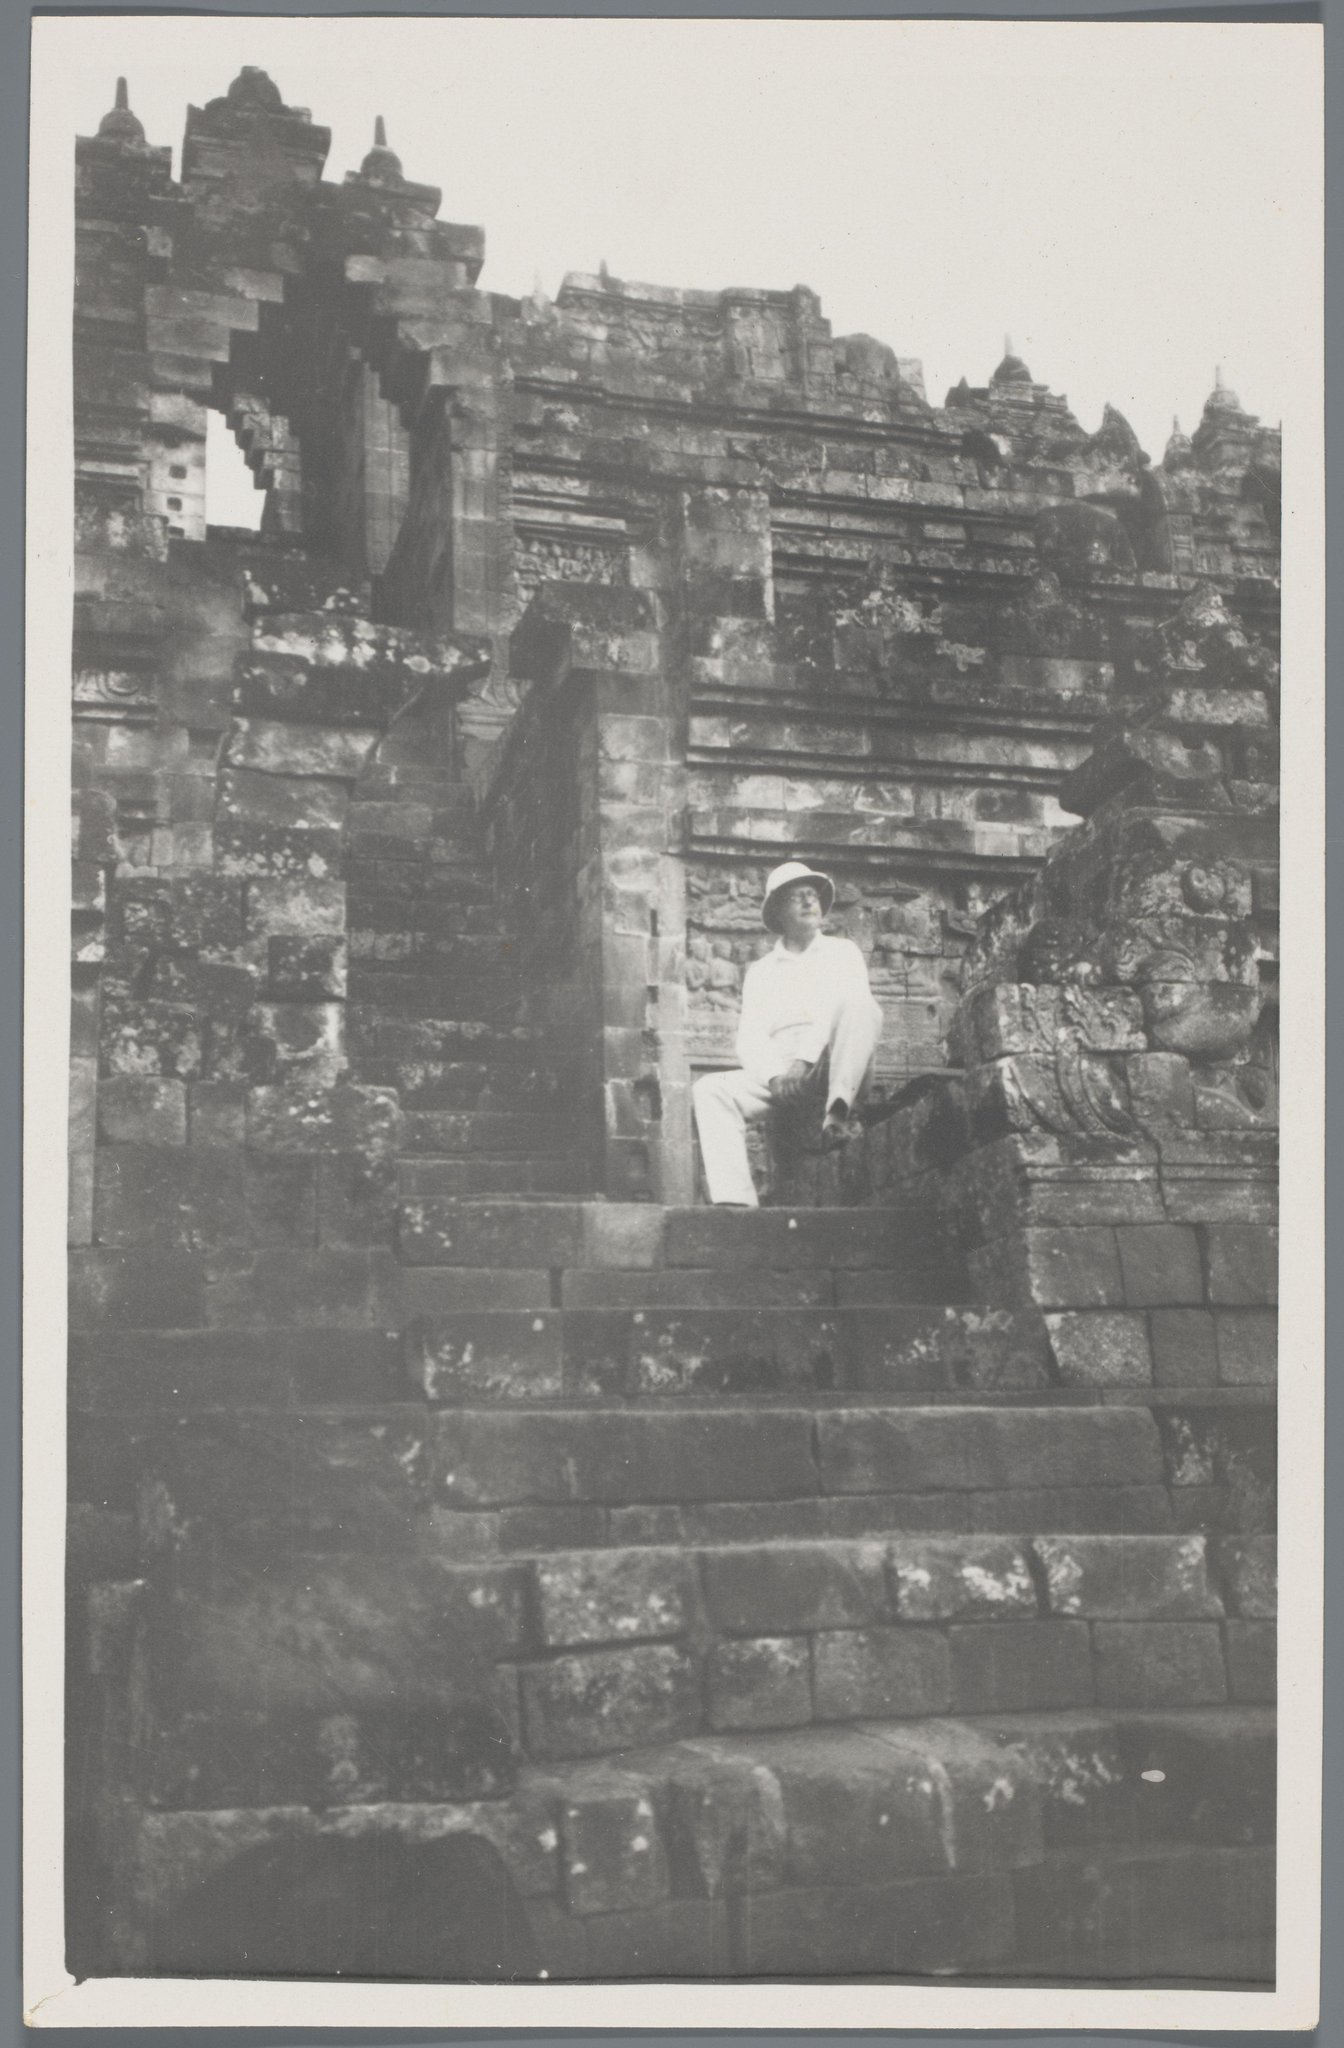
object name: photograph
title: Foto behorende bij het fotoalbum Reis door Azië van H.K. Westendorp en B. Osieck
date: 1930-1931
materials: photographic support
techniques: gelatin silver print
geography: asia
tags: azië